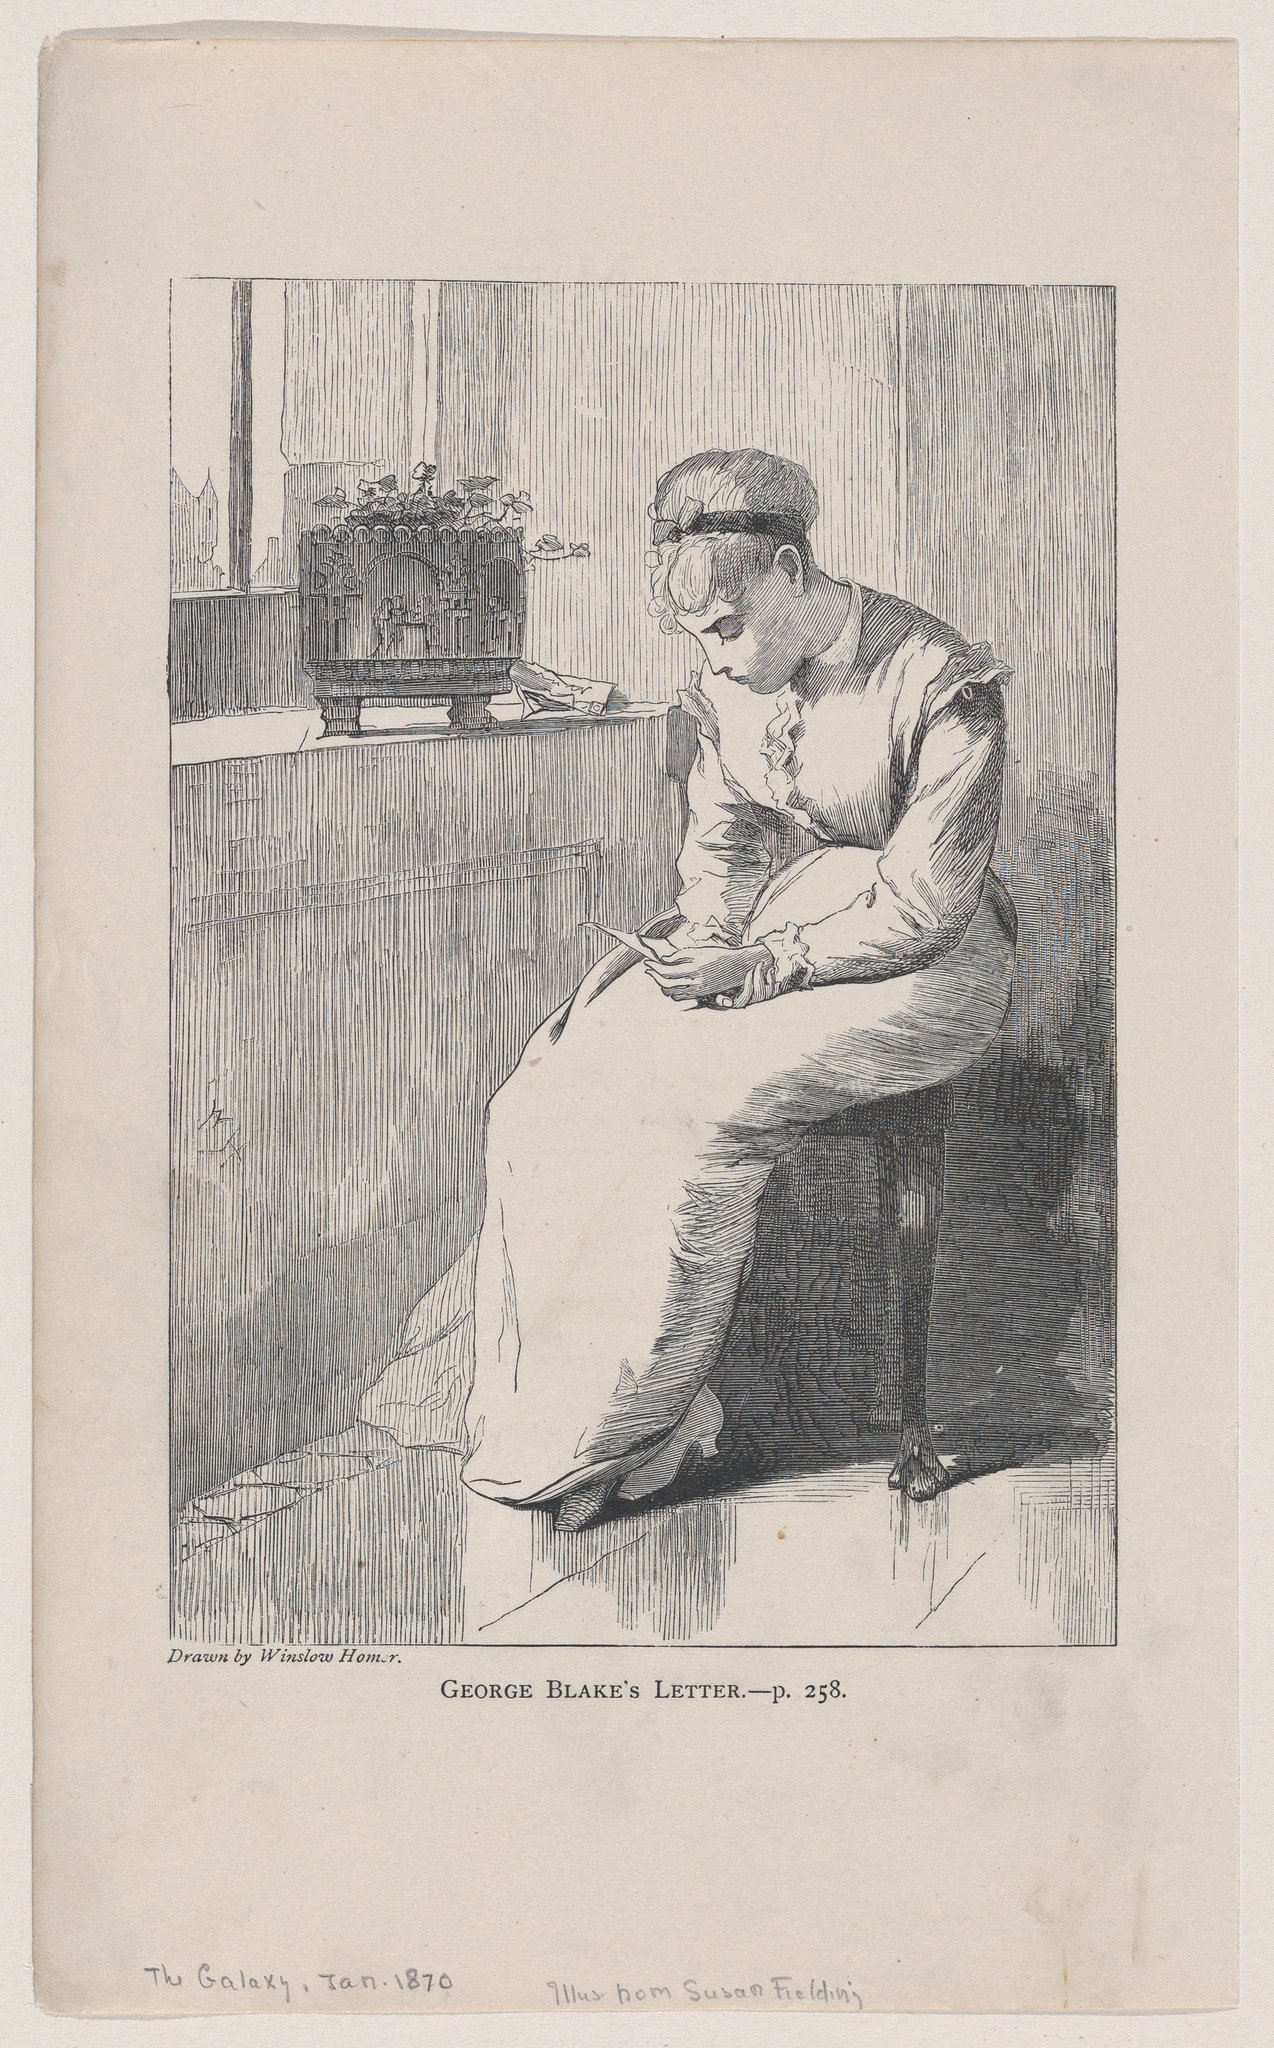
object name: print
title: George Blake's Letter (The Galaxy, An Illustrated Magazine of Entertaining Reading, Vol. IX)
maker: winslow homer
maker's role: artist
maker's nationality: american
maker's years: 1836-1910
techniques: engraving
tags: women,reading